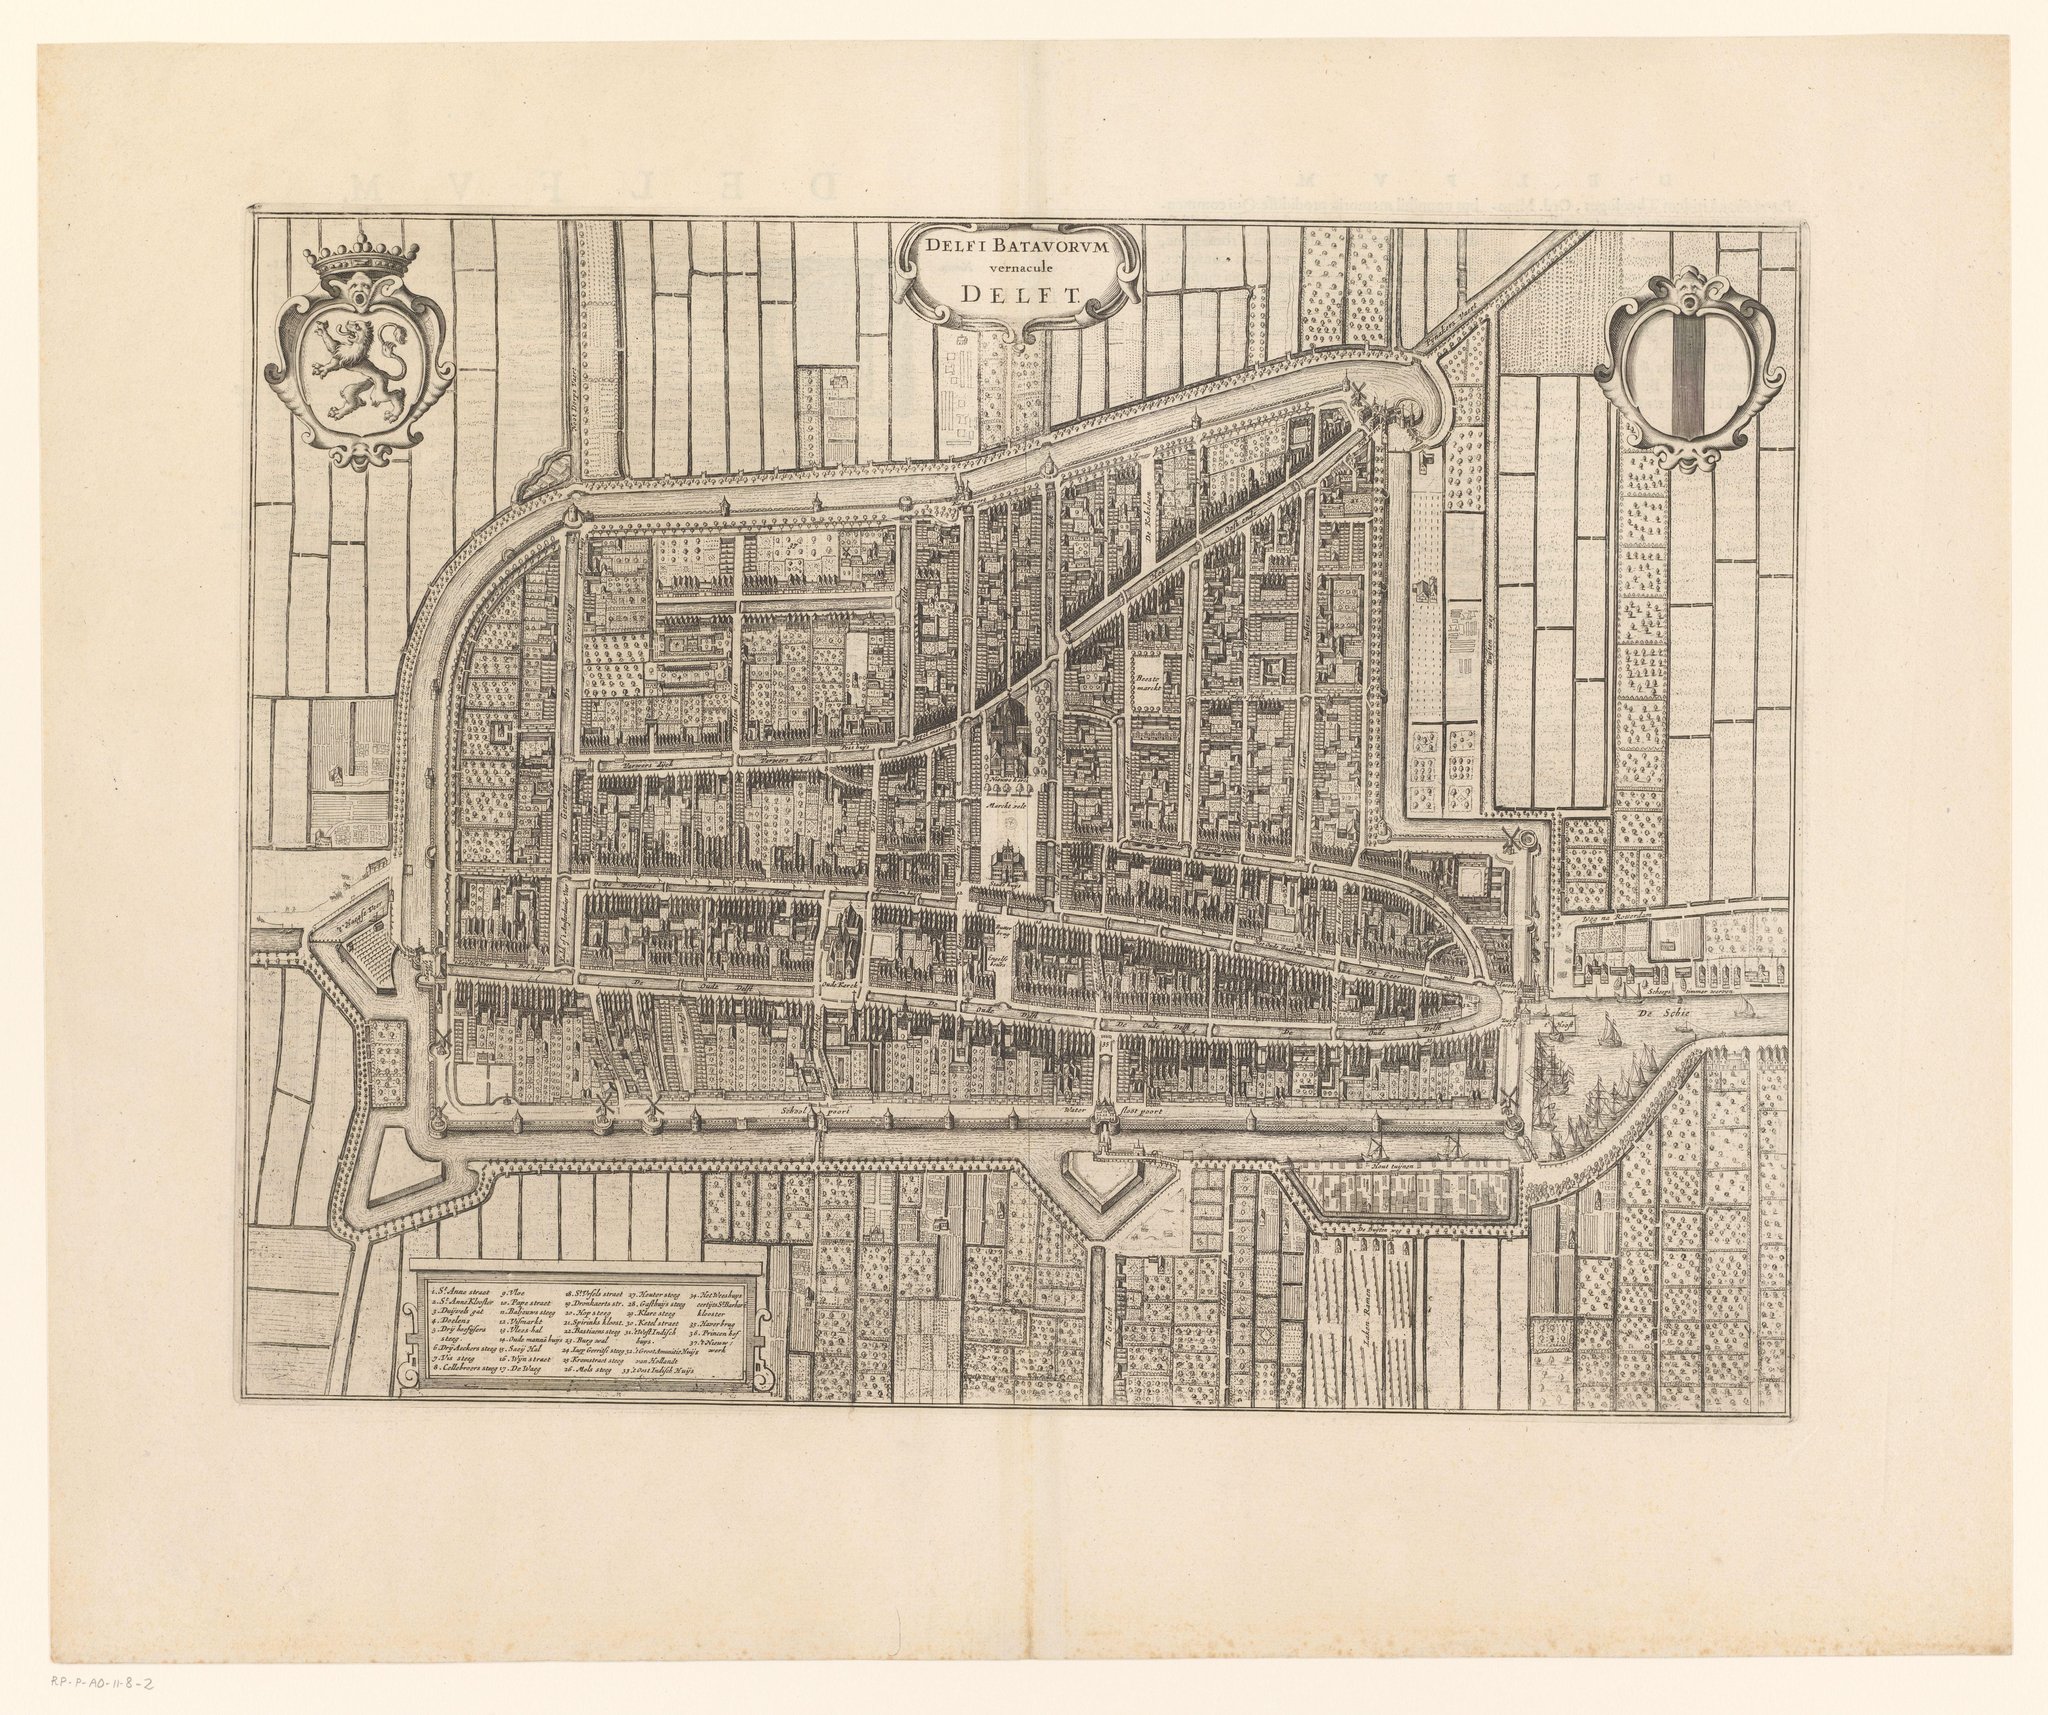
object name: print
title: Plattegrond van Delft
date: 1652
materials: paper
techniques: engraving, etching, letterpress printing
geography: amsterdam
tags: coat of arms (as symbol of the state, etc.) (+ city; municipal), maps of cities, coat of arms (as symbol of the state, etc.) (+ province; provincial), delft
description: Prent gebruikt in: Blaeu, Johannes Willemszoon. Novum ac magnum theatrum urbium Belgicae (...). 2 delen. 3e druk. Amsterdam: Johannes Willemszoon Blaeu, 1652, dl. 1.